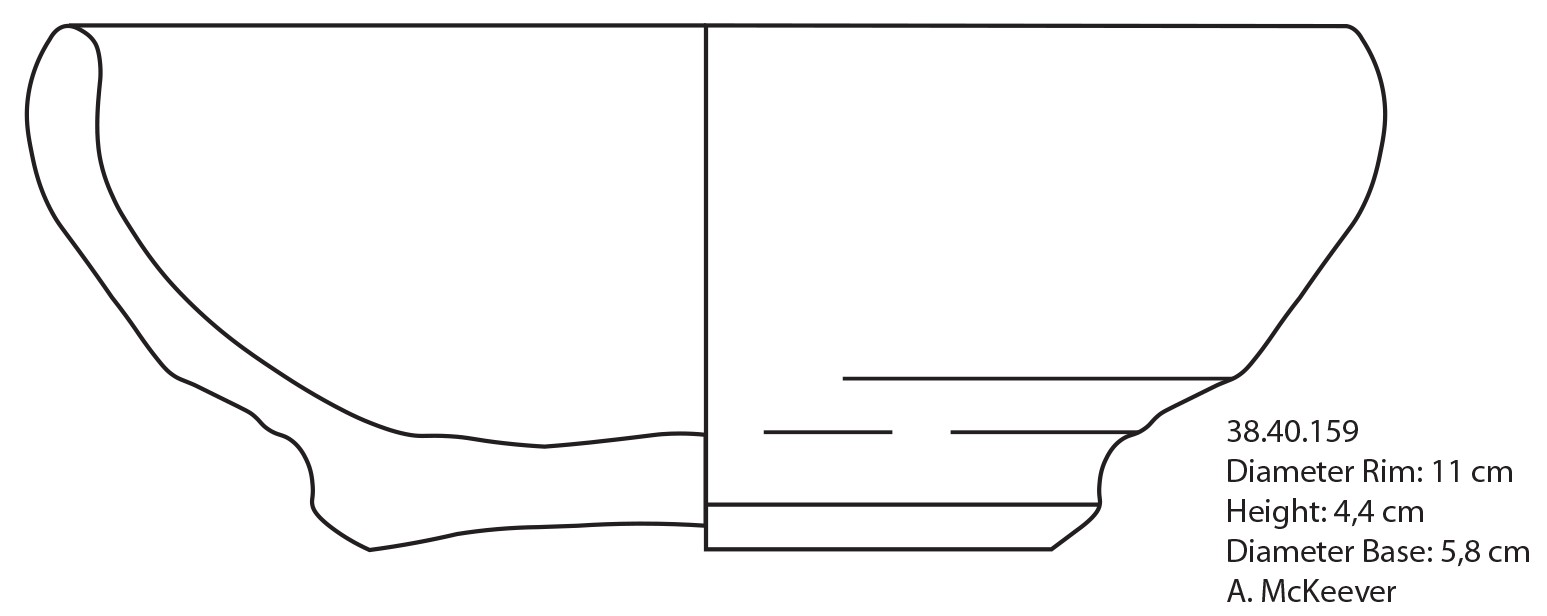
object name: bowl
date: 801-900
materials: earthenware, glaze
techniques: polychrome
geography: iran